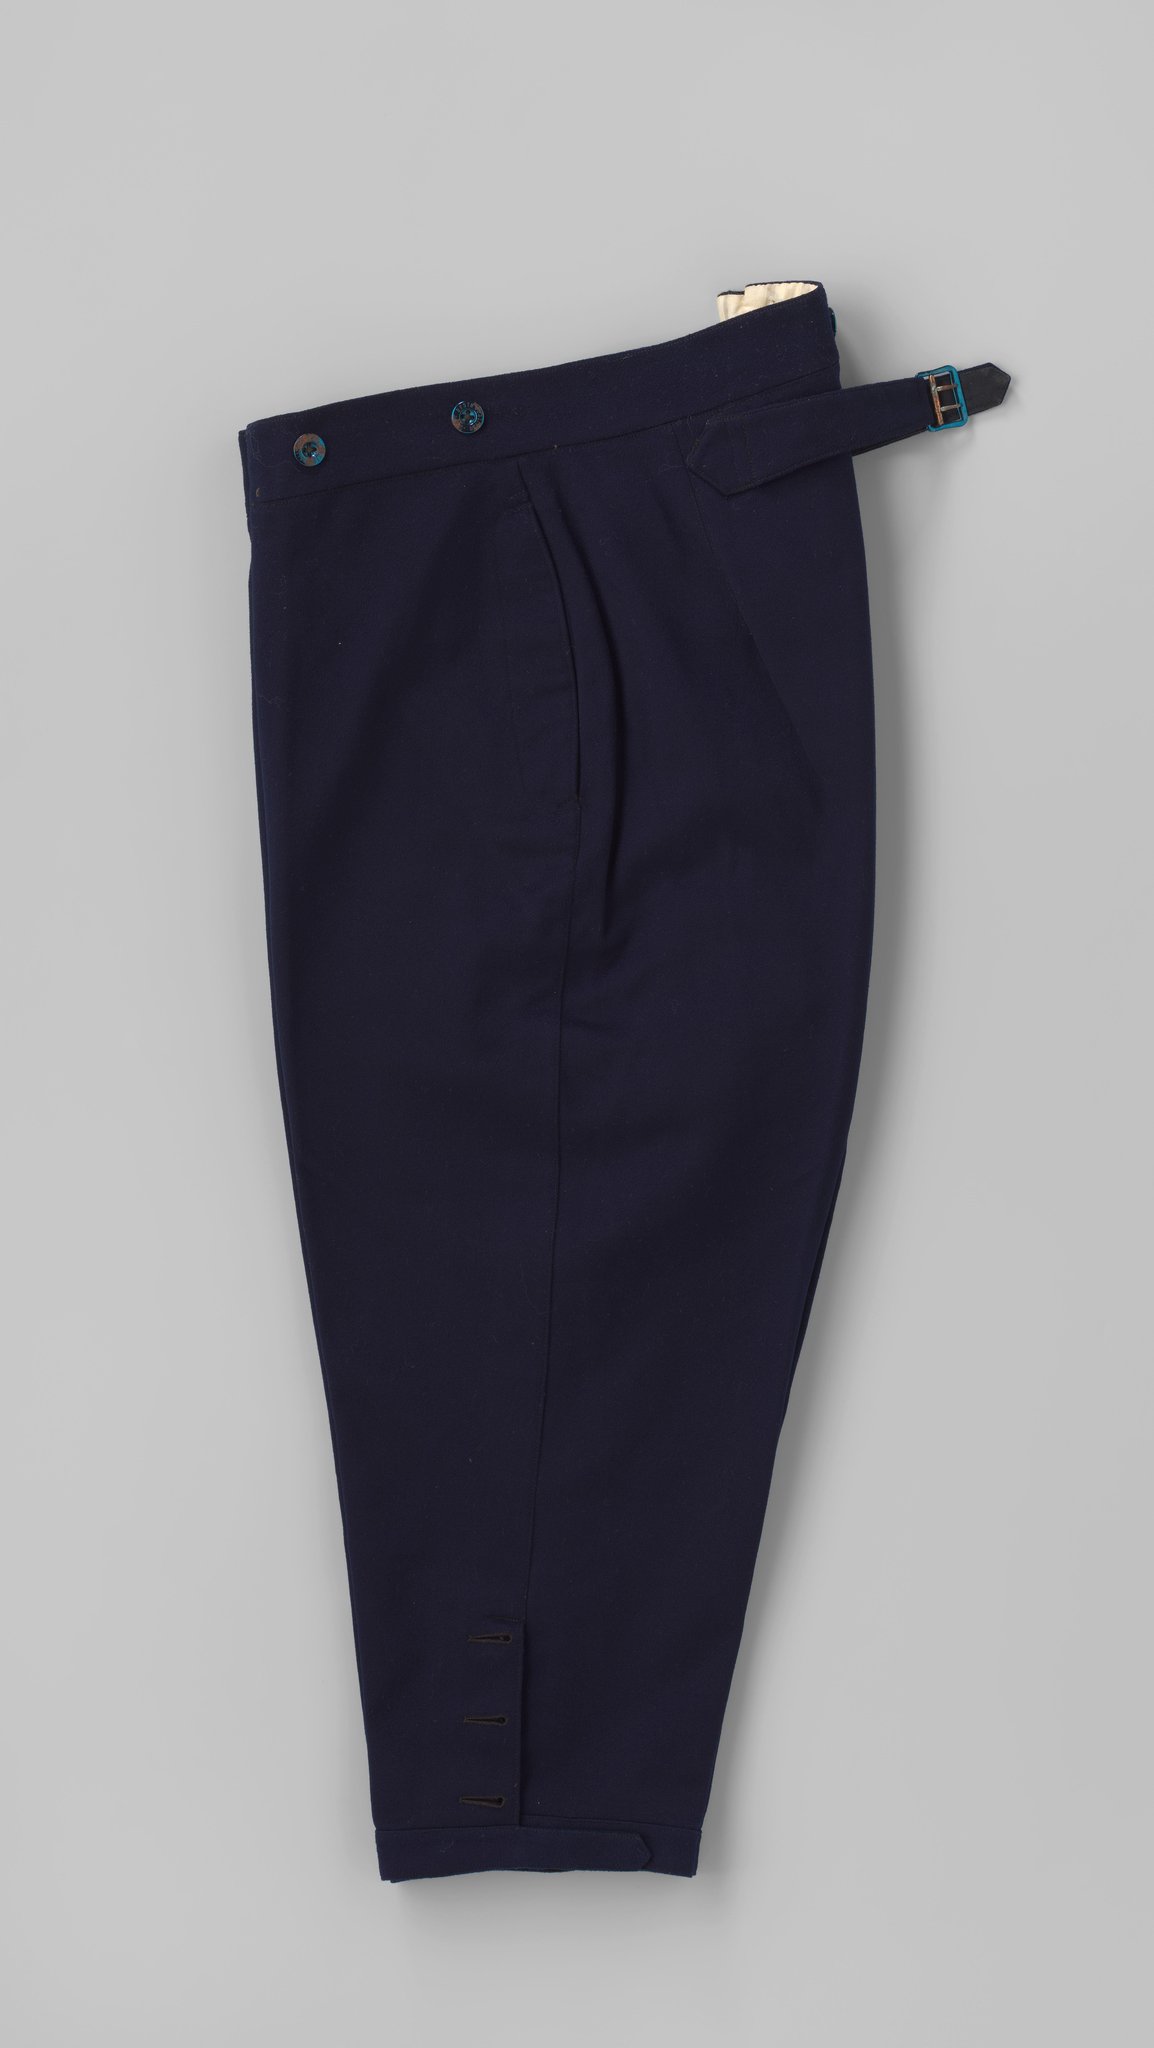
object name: main garment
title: Kniebroek met drie zwarte zijden knopen en gespsluiting onderaan de pijp en blauwe metalen knopen, van blauw laken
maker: w.a. molenaar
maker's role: kleermaker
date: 1911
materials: textile, silk, wool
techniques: weave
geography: beverwijk